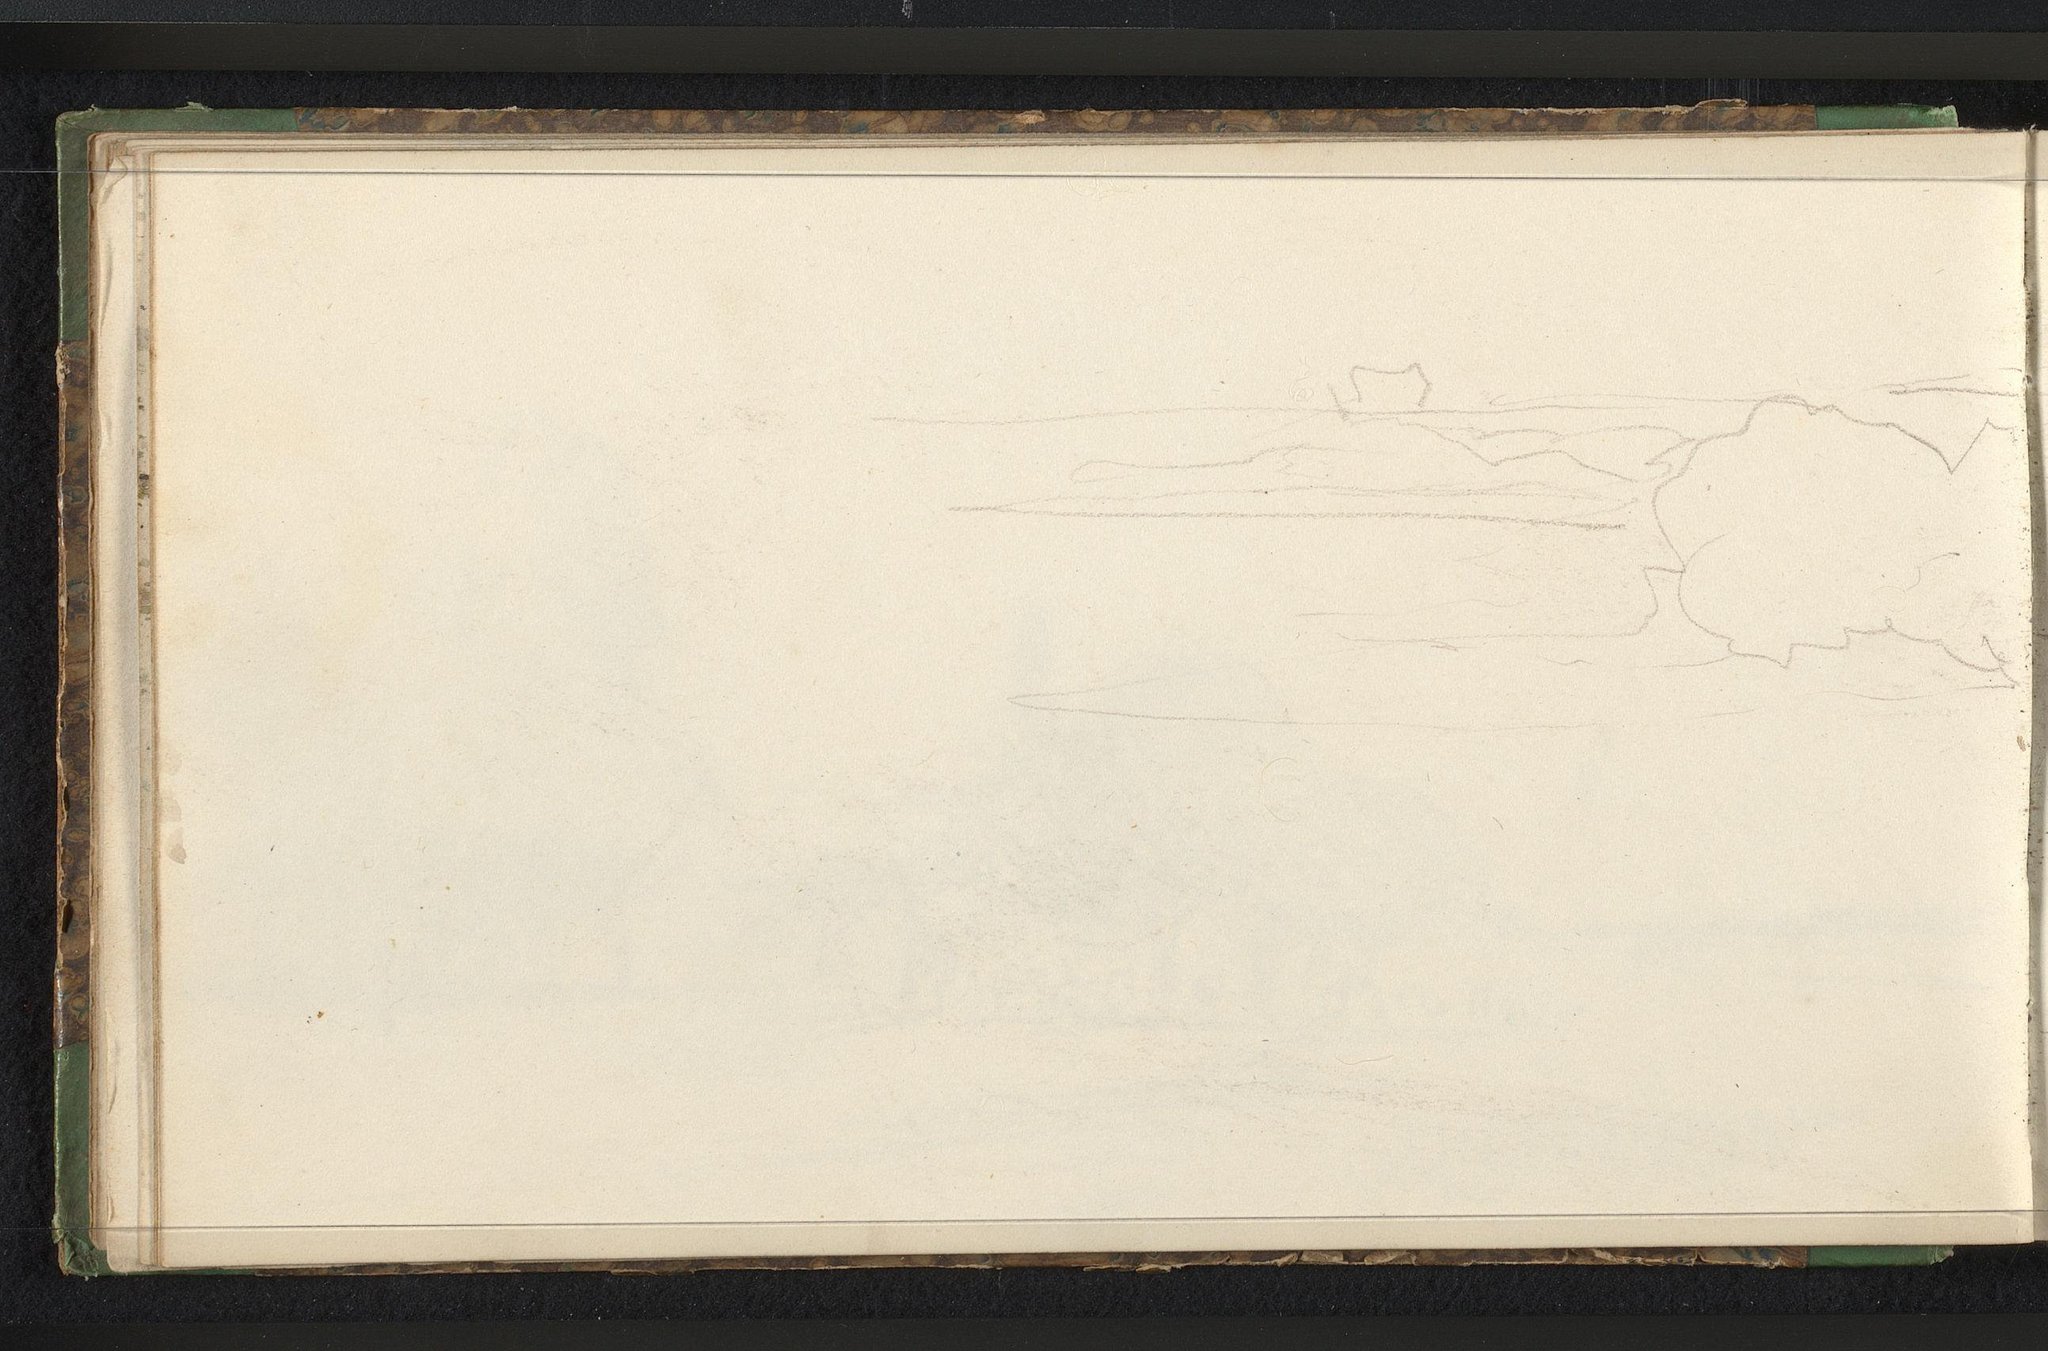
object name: sketchbook leaf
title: Deel van landschap op pagina 25(R)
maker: jan bedijs tom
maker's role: draughtsman, painter, print maker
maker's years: 1813-1894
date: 1828-1894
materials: paper, pencil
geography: the hague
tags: landscapes, artist (in general) making preliminary designs, sketching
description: Pagina 24 verso uit een schetsboek met 50 bladen.